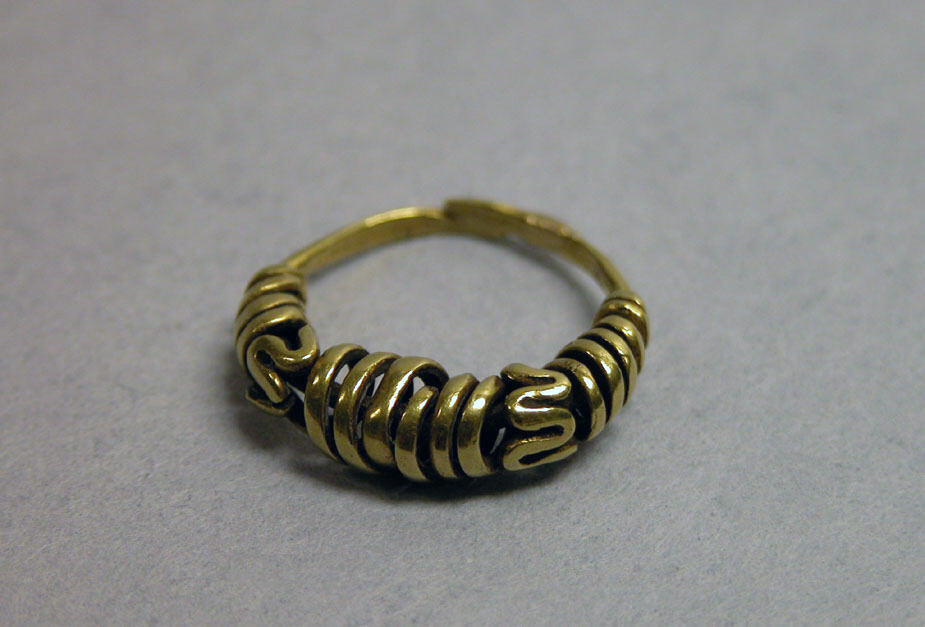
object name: ring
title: Ring with Twisted Coil Motif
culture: indonesian, javanese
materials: gold